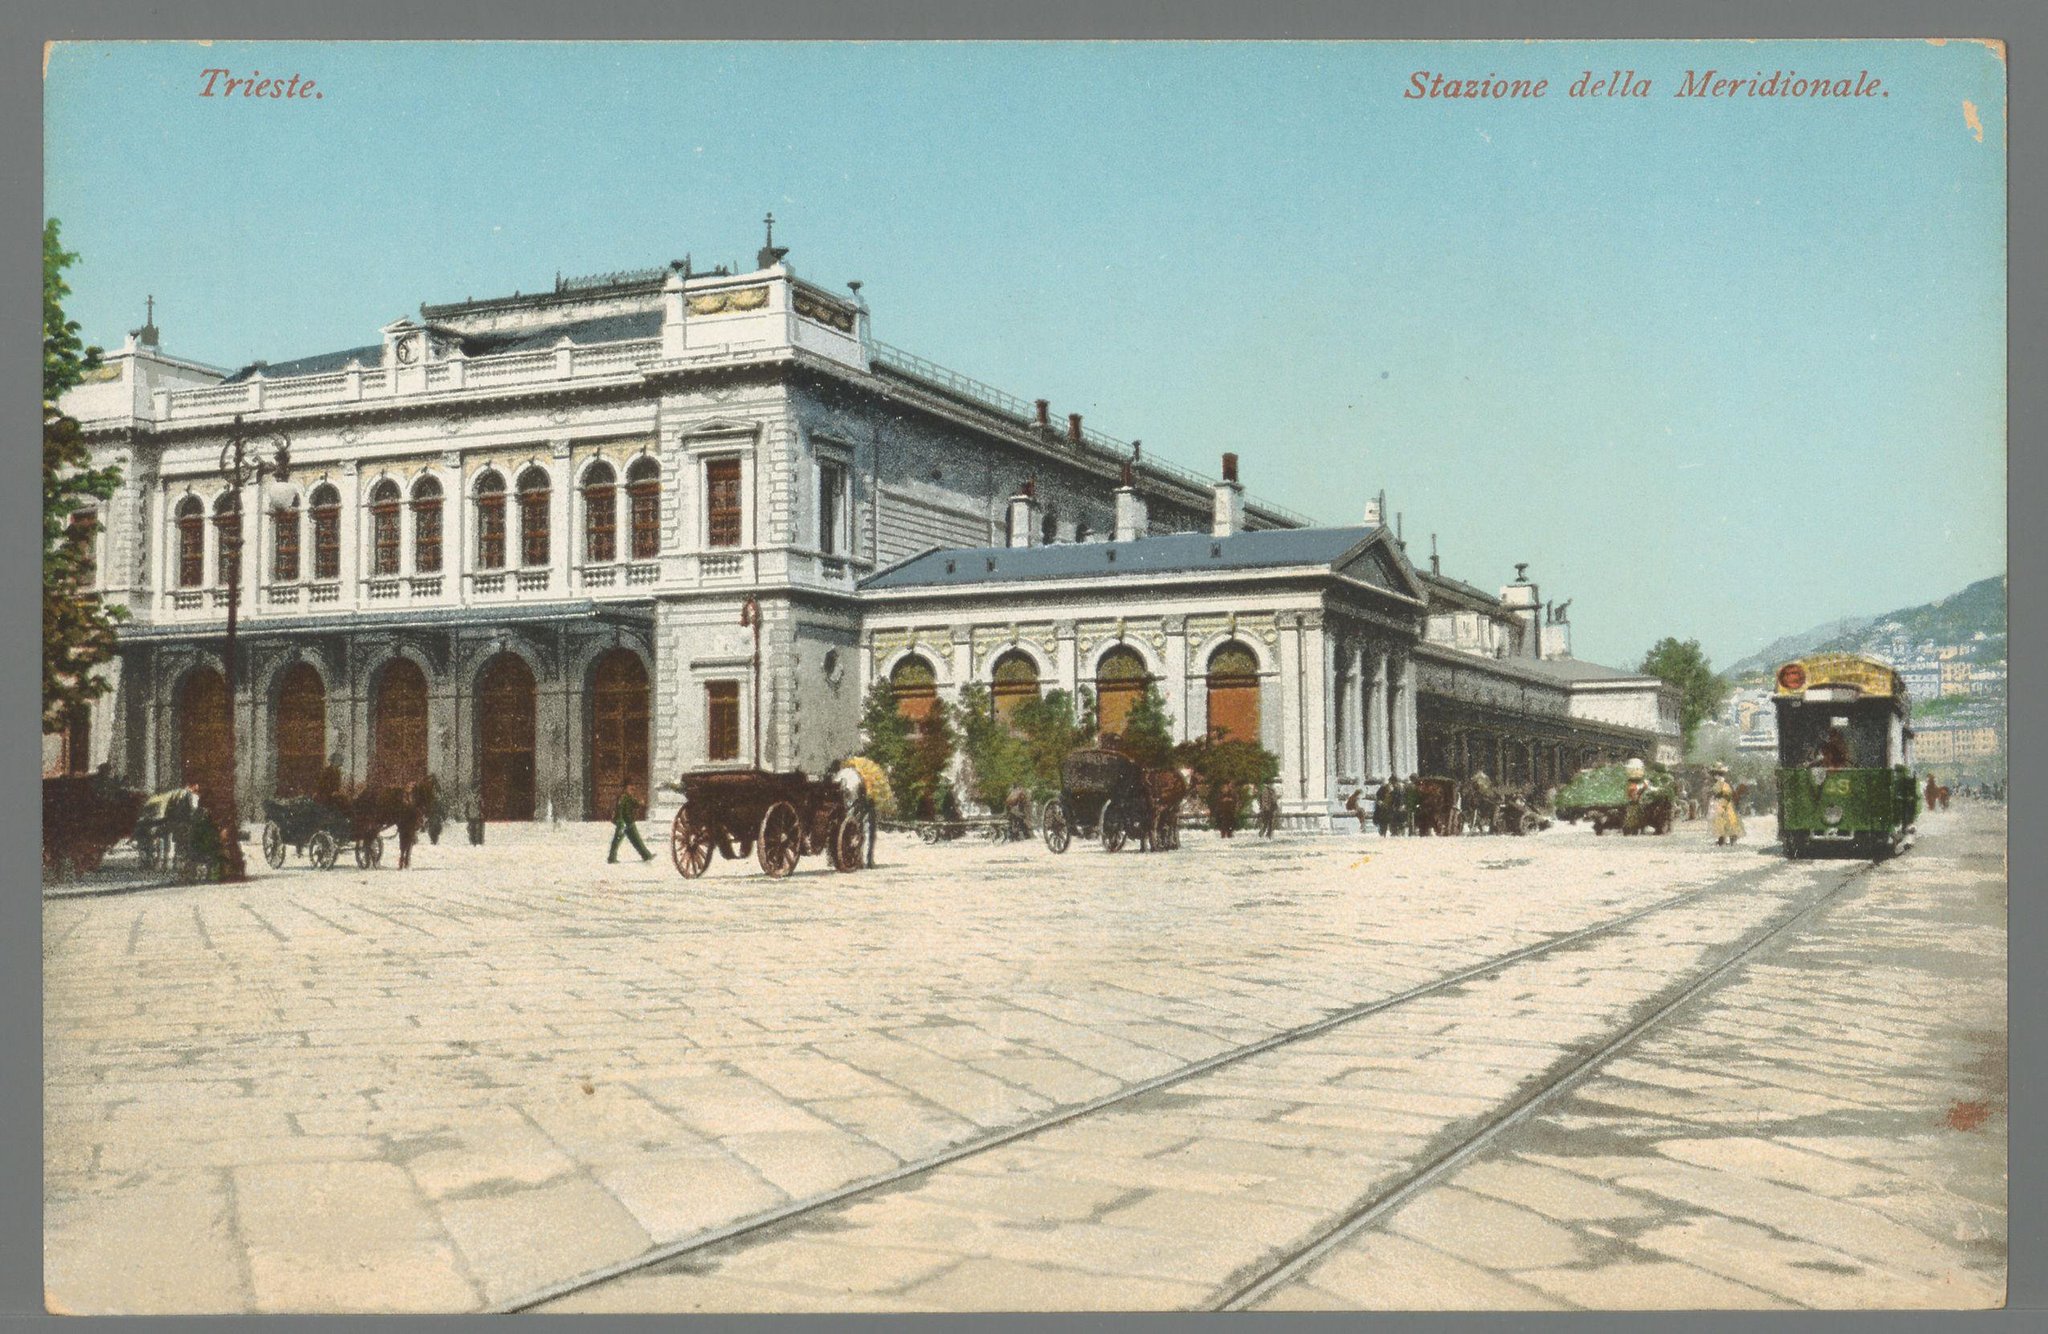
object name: photomechanical print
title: Trieste. Stazione della Meridionale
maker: Anonymous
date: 1906-1909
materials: cardboard, photographic process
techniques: writing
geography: munich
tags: tram, station; shelter (railway, tramway), city-view, and landscape with man-made constructions (+ city(-scape) with figures, staffage)